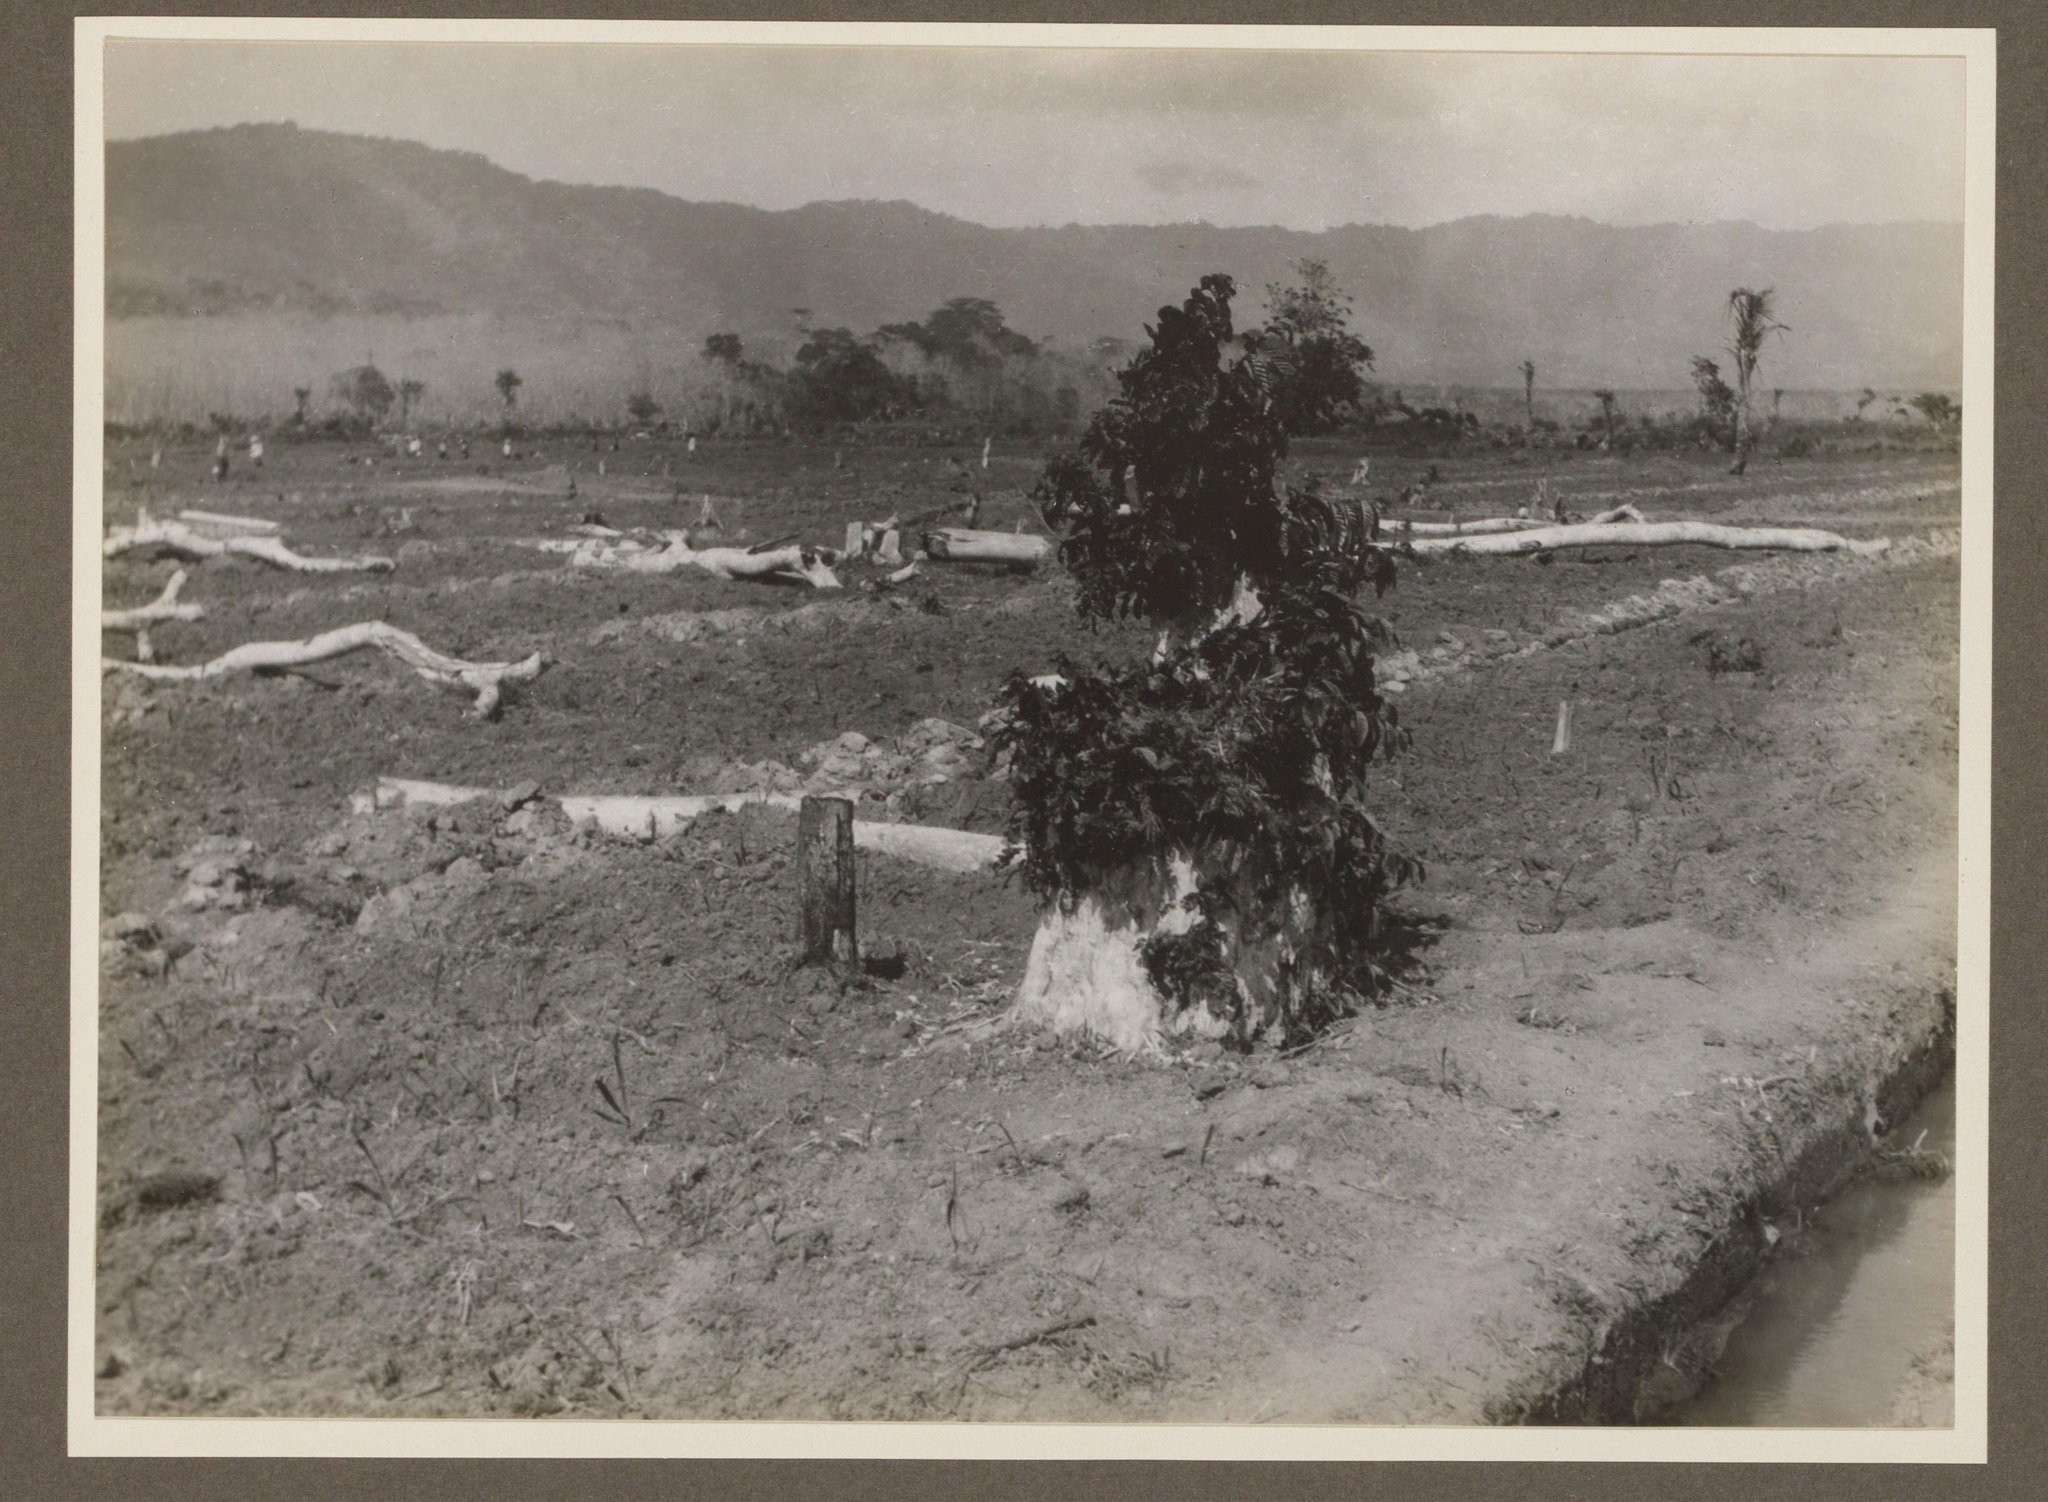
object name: photograph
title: Eerste rietaanplant Bedadoeng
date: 1904-1931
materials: photographic support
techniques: gelatin silver print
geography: surabaya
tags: colonial system, plantation, trade-company, (non-fruit) products of plants or trees: sugarcane, surabaya, java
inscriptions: inscription: ‘Eerste rietaanplant Bedadoeng’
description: Velden met jonge aanplant van suikerriet te Bedadoeng. Foto in het het fotoalbum aangeboden aan A. van der Eyk namens de chefs en het personeel van de Handelsvereniging Amsterdam (HVA) te Soerabaja bij zijn vertrek van Java in april 1931.